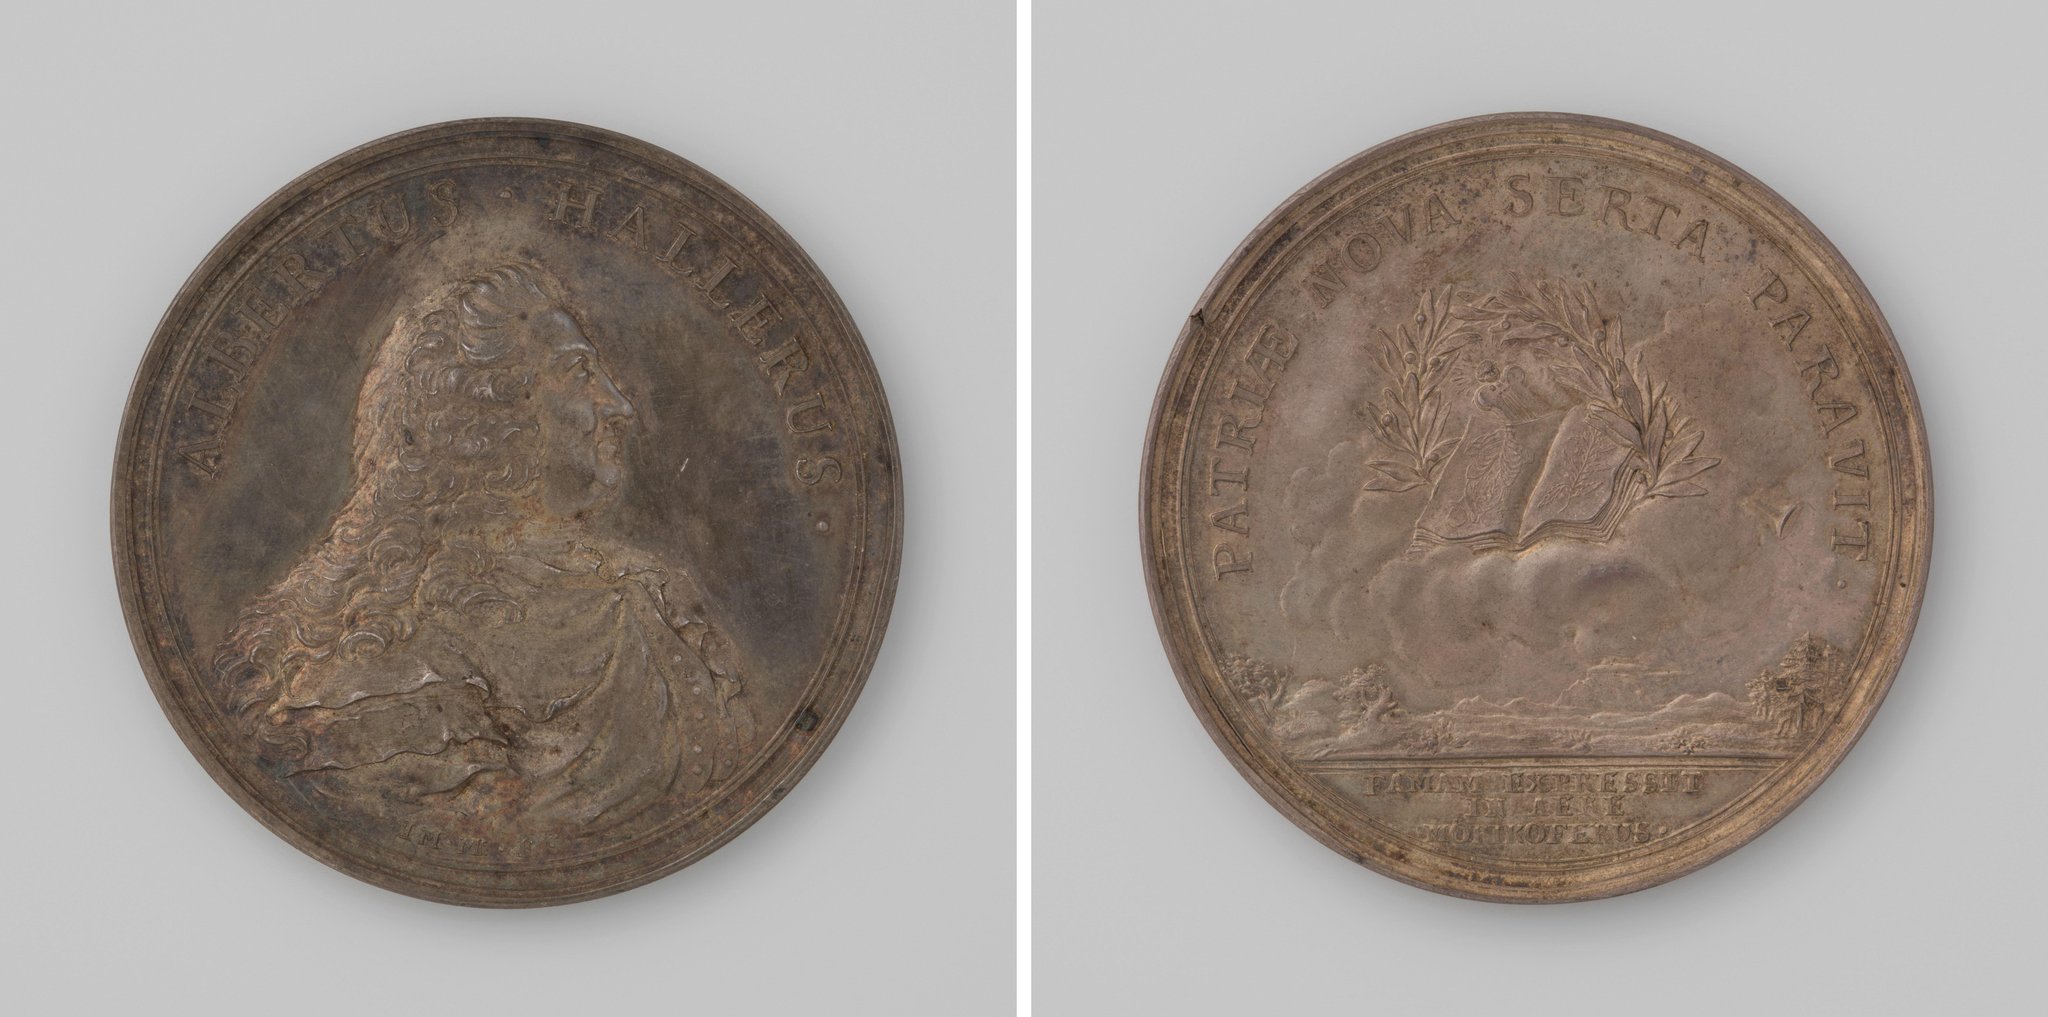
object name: history medal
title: Albrecht von Haller, natuurkundige, bioloog en dichter te Bern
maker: johann melchior mörikofer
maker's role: medailleur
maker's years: 1706-1761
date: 1754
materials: silver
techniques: striking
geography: bern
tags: switzerland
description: Zilveren penning. Voorzijde: borststuk man binnen omschrift. Keerzijde: open boek en lier binnen lauwerkrans op wolk binnen omschrift; afsnede: opschrift